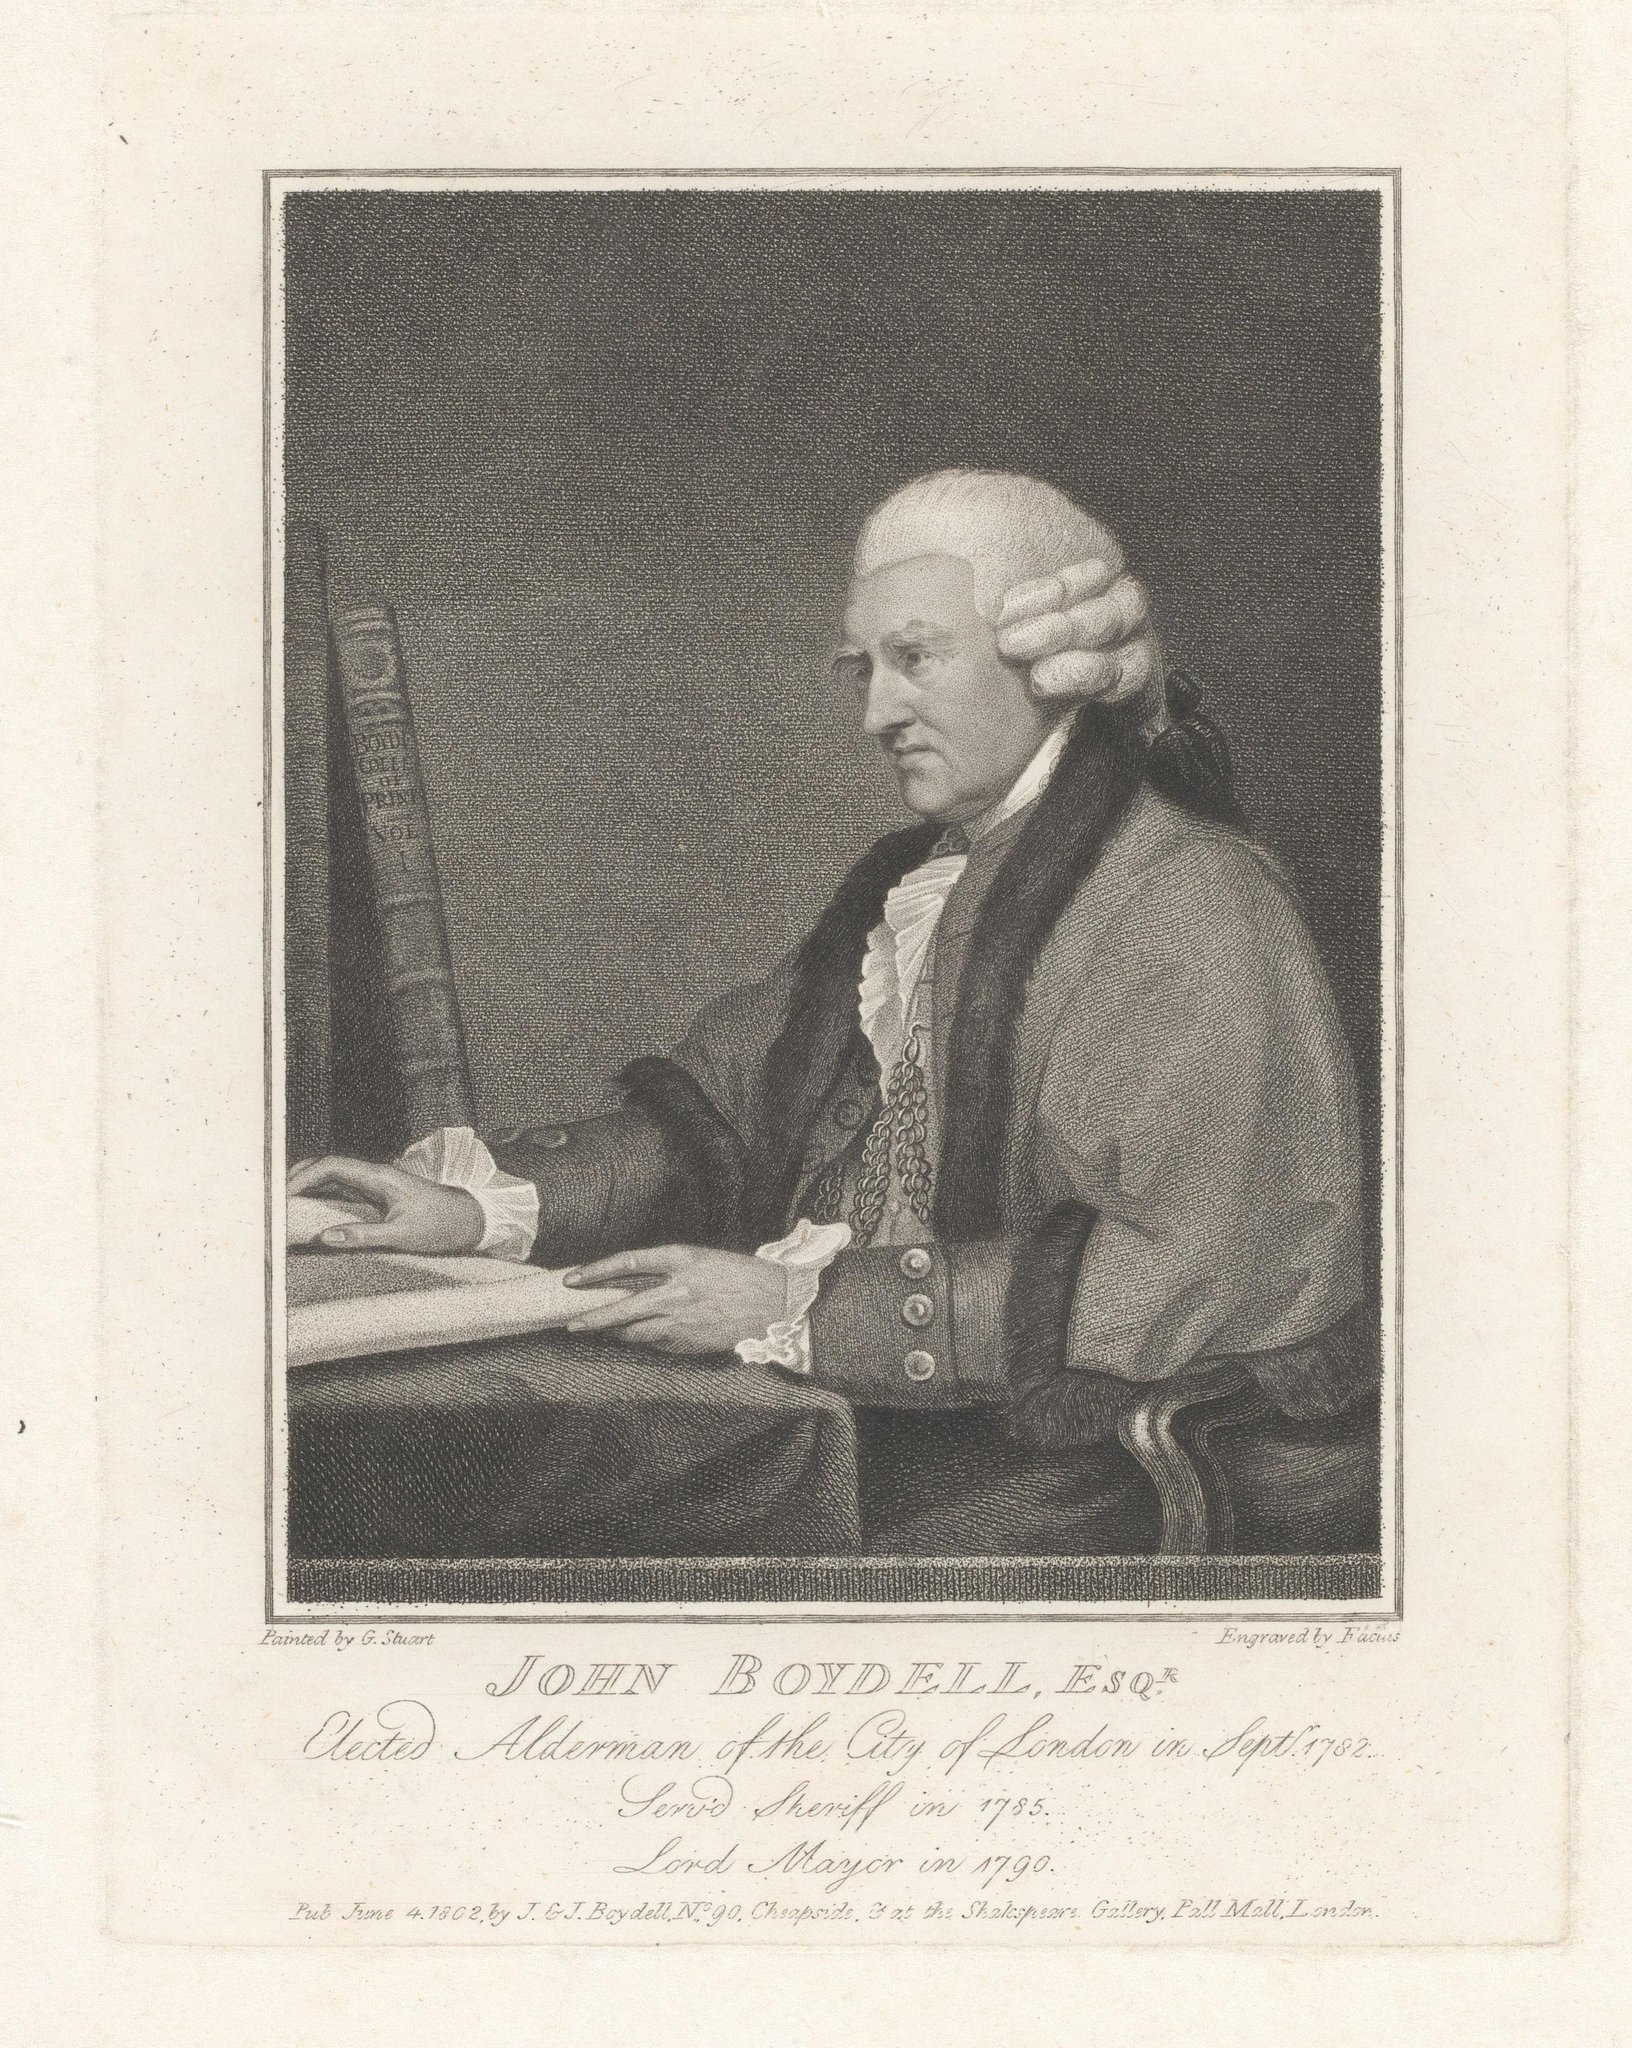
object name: print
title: Portret van de prentuitgever John Boydell, Esq.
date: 1802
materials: paper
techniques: engraving, etching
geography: london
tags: london, print maker, draughtsman, publisher, john boydell, publishing, publisher (+ portrait of scholar, scientist), historical persons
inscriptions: collector's mark: Lugt 2228, collector's mark: Lugt 2760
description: De geportretteerde is afgebeeld ten halve lijve zittend in een stoel met voor zich op tafel een prent en een prentalbum met opschrift.